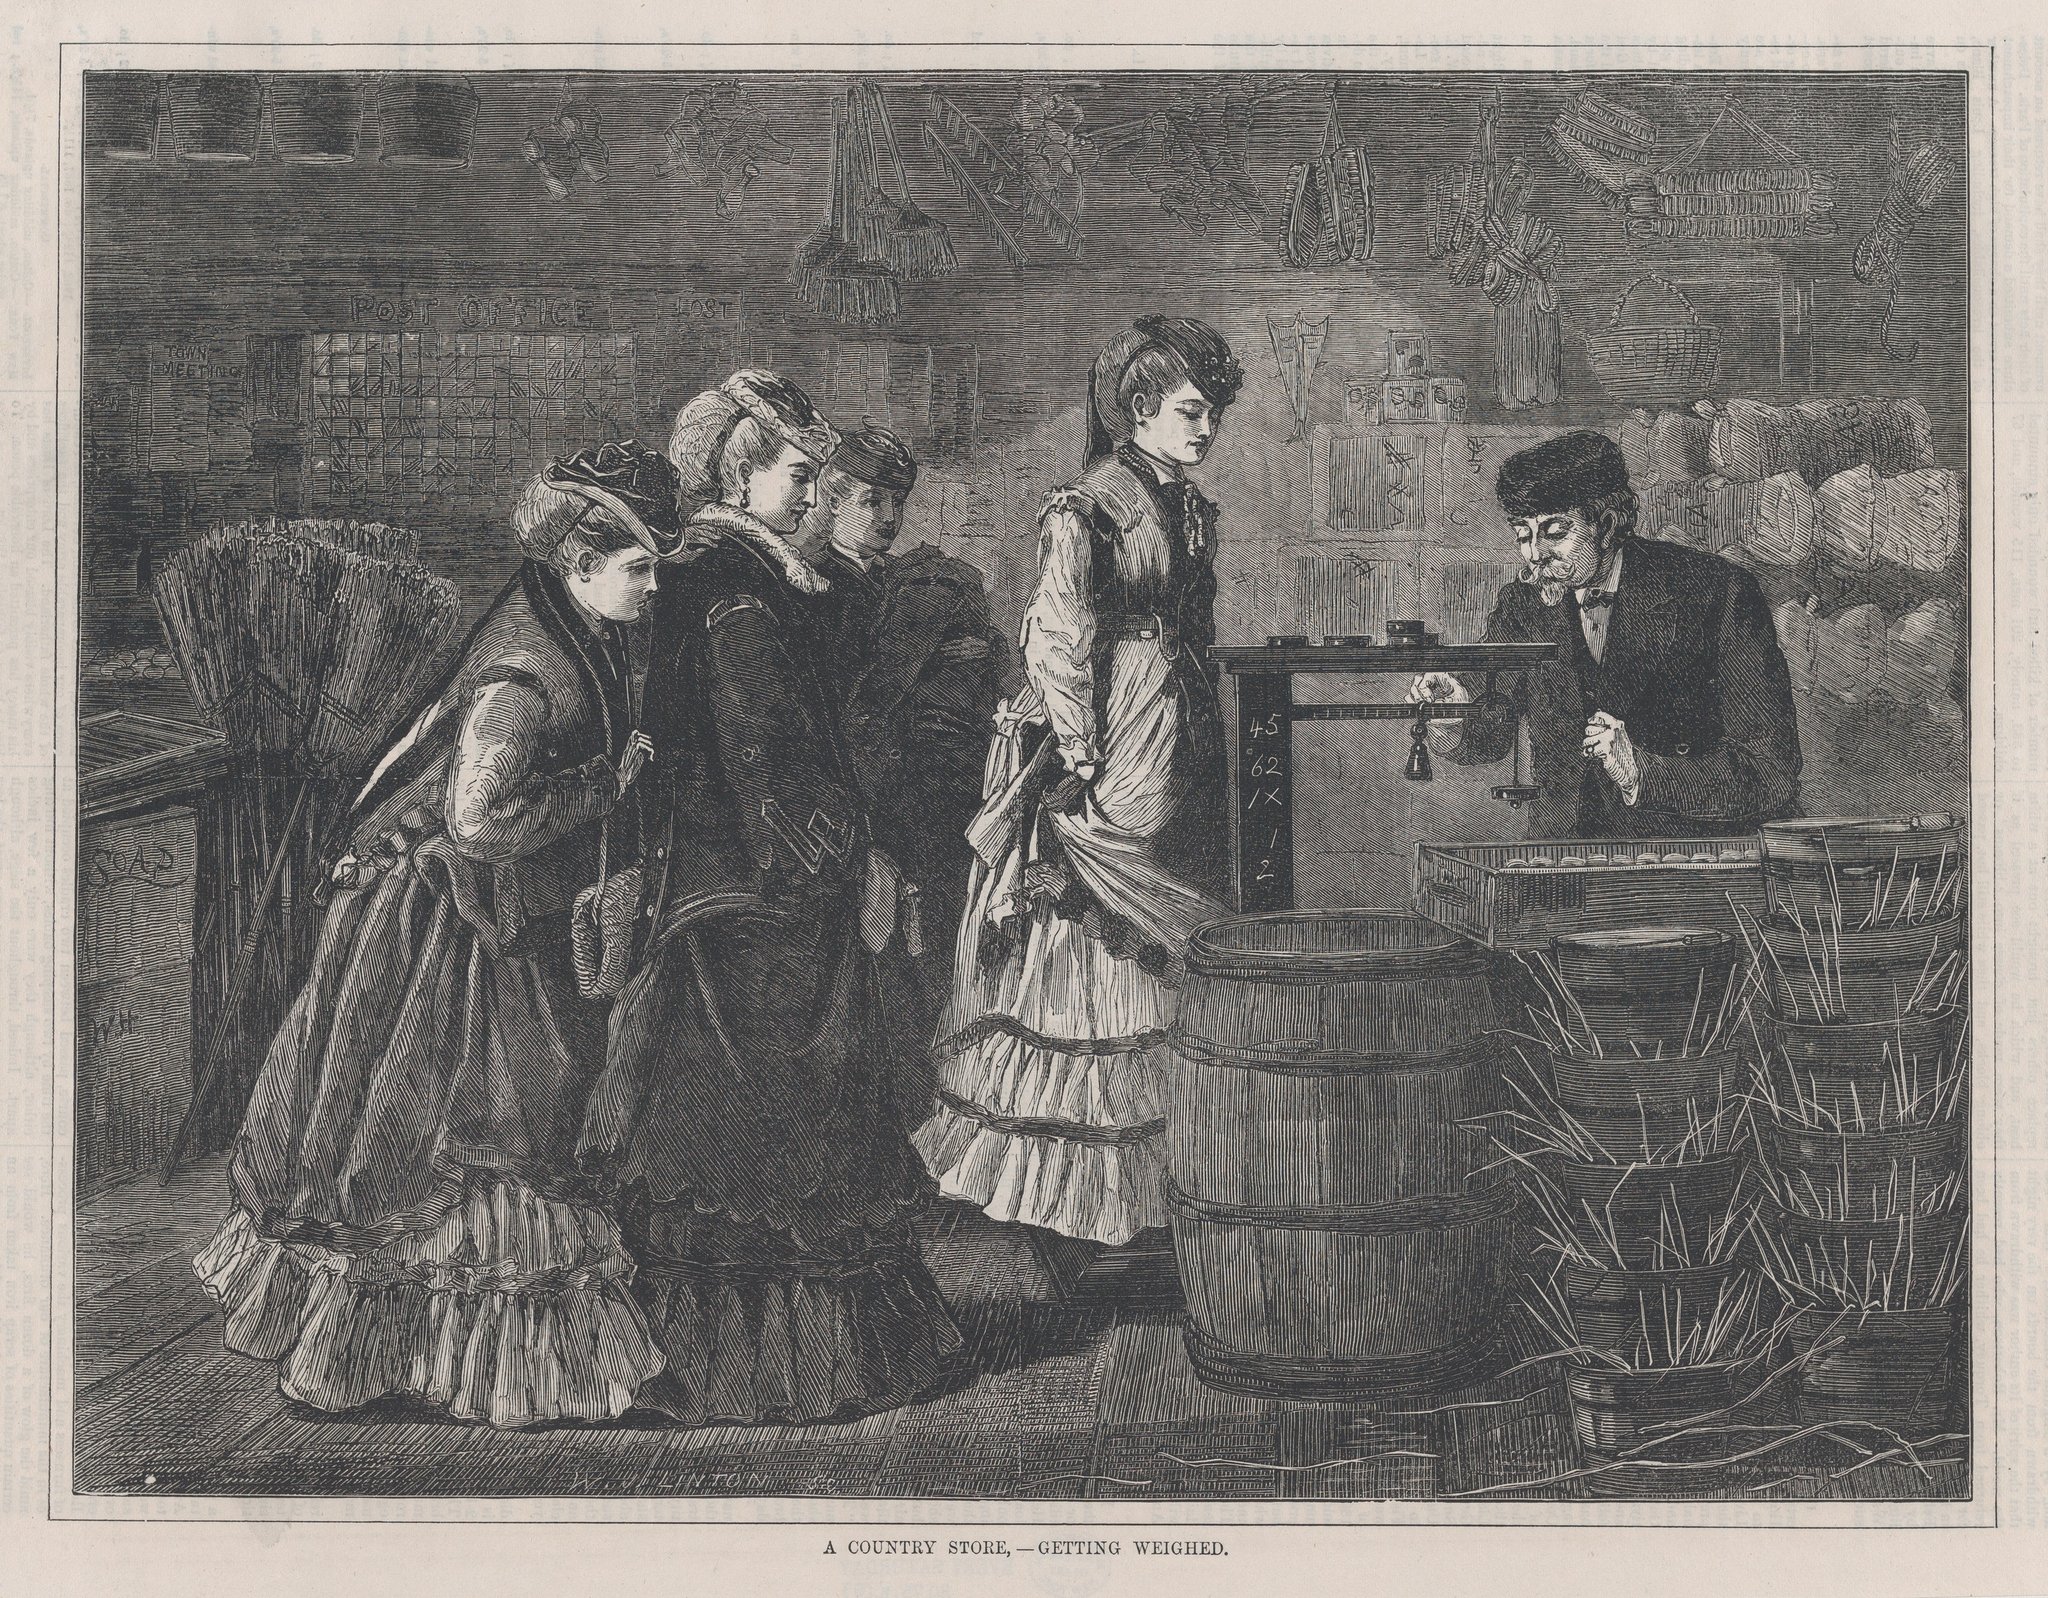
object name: print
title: A Country Store – Getting Weighed (Every Saturday, Vol. II, New Series)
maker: winslow homer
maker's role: artist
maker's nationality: american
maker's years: 1836-1910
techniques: engraving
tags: men,women,scales